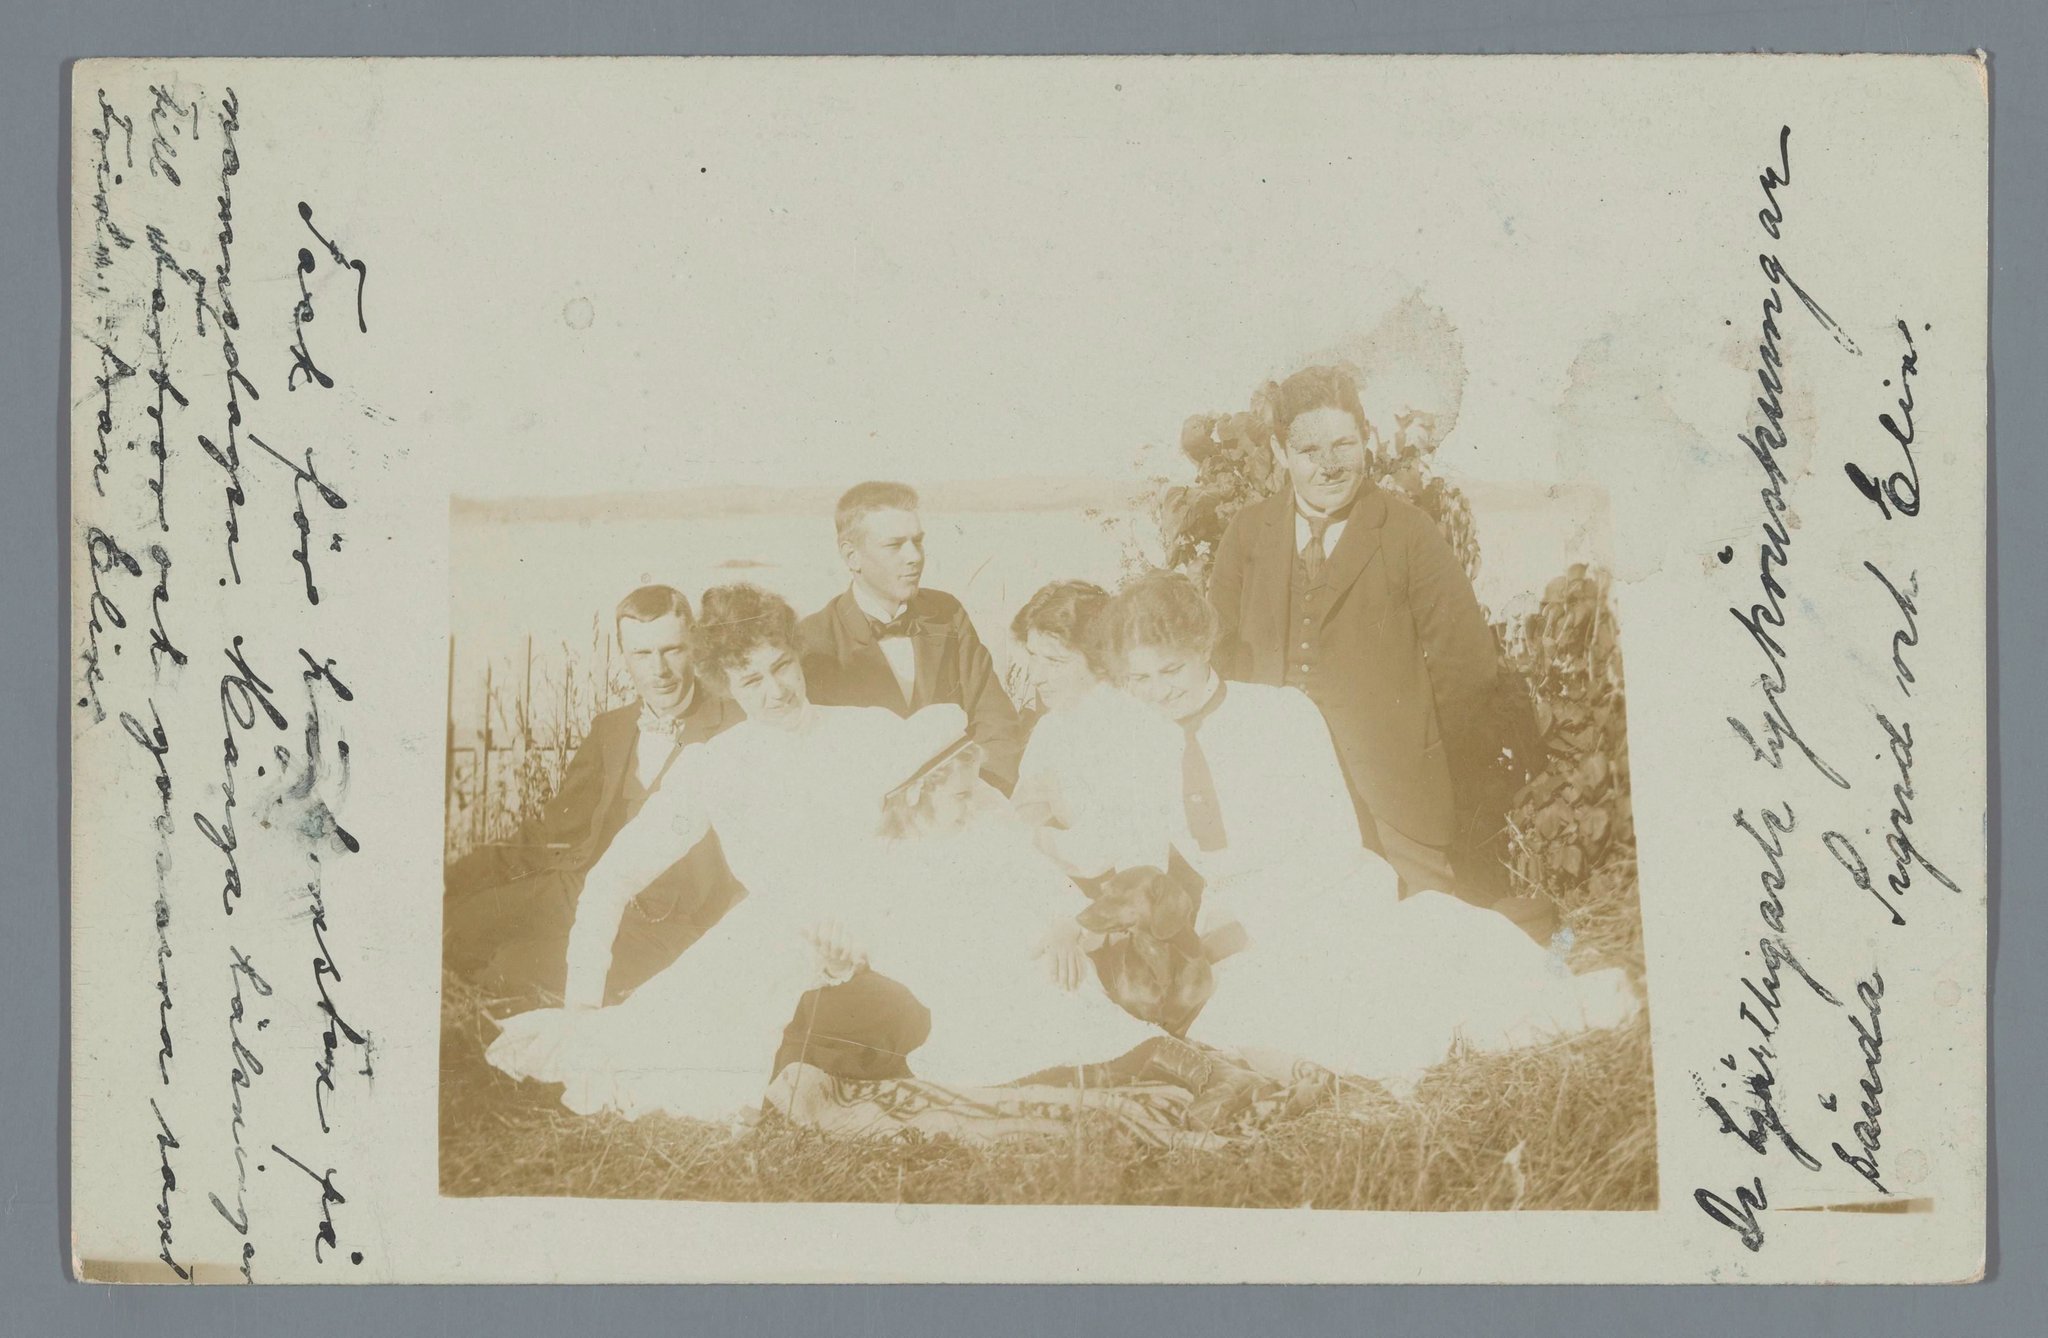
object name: photograph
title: Groepsportret van een onbekend gezelschap voor een meer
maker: Anonymous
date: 1901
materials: photographic support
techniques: daylight paper print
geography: sweden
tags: lake, anonymous historical persons portrayed in a group, in a group-portrait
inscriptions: inscription: ‘1901’, inscription: ‘Tack för (...)Sigrid och Elin.’